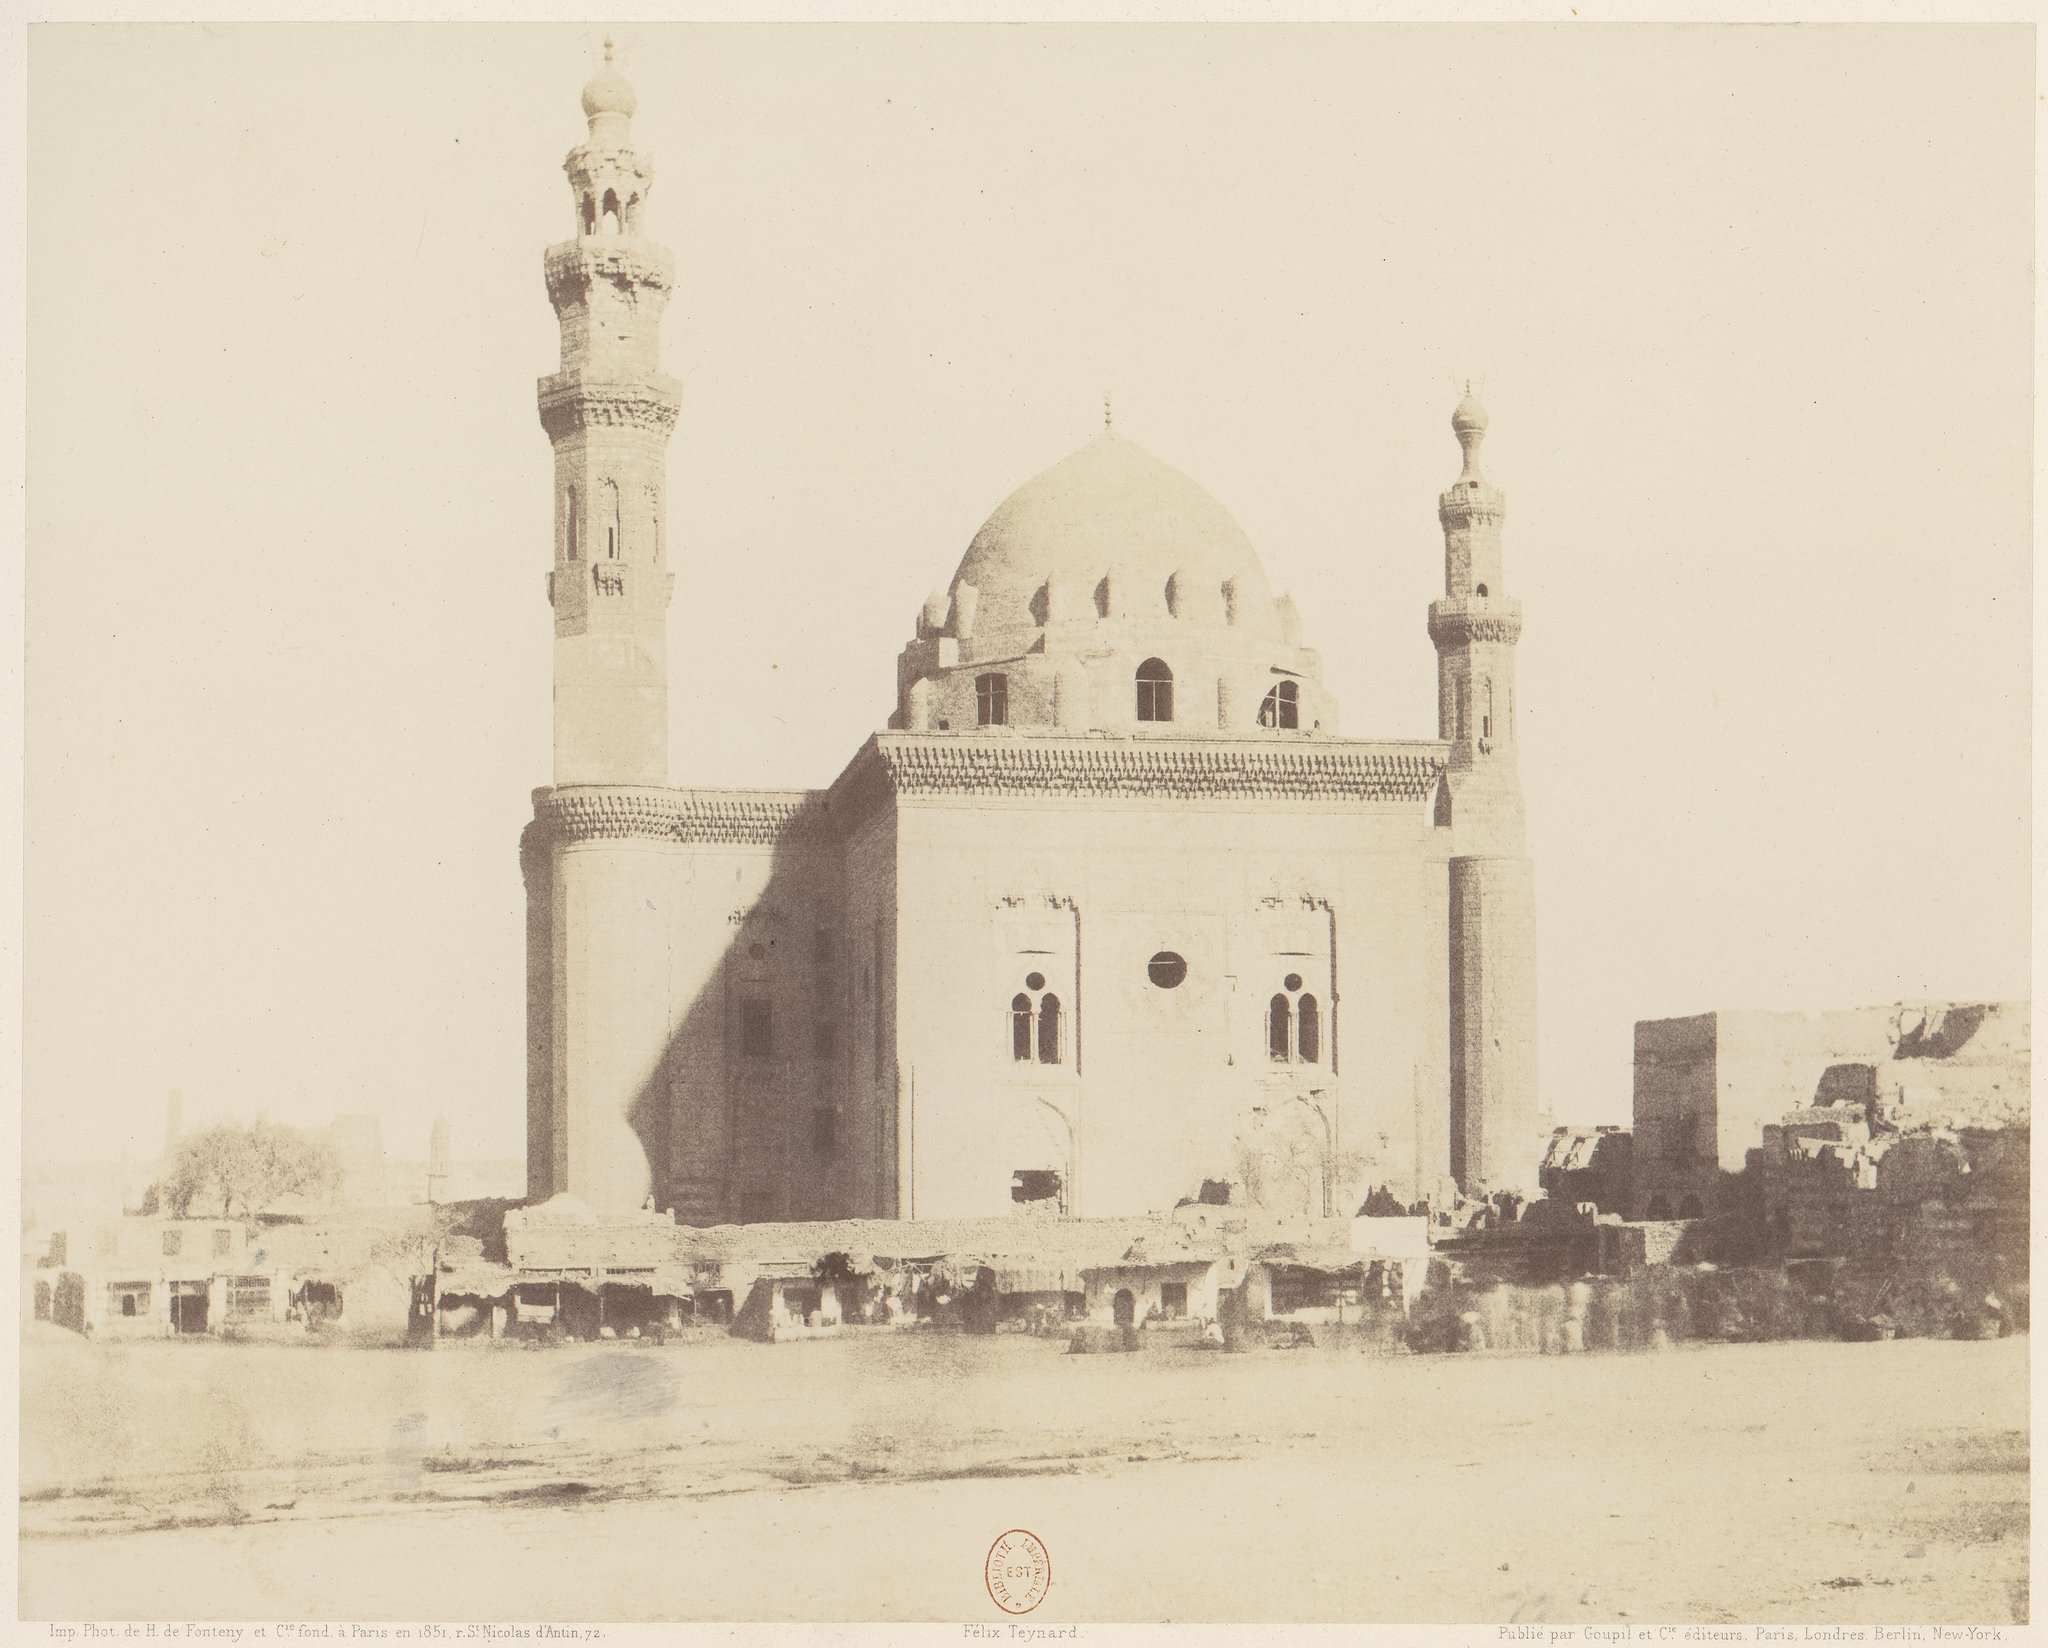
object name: photograph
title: Le Kaire, Mosquée du Sultan Haçan (le Tombeau)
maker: félix teynard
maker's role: artist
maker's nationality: french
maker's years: 1817-1892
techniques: paper negative, salted paper print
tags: mosques